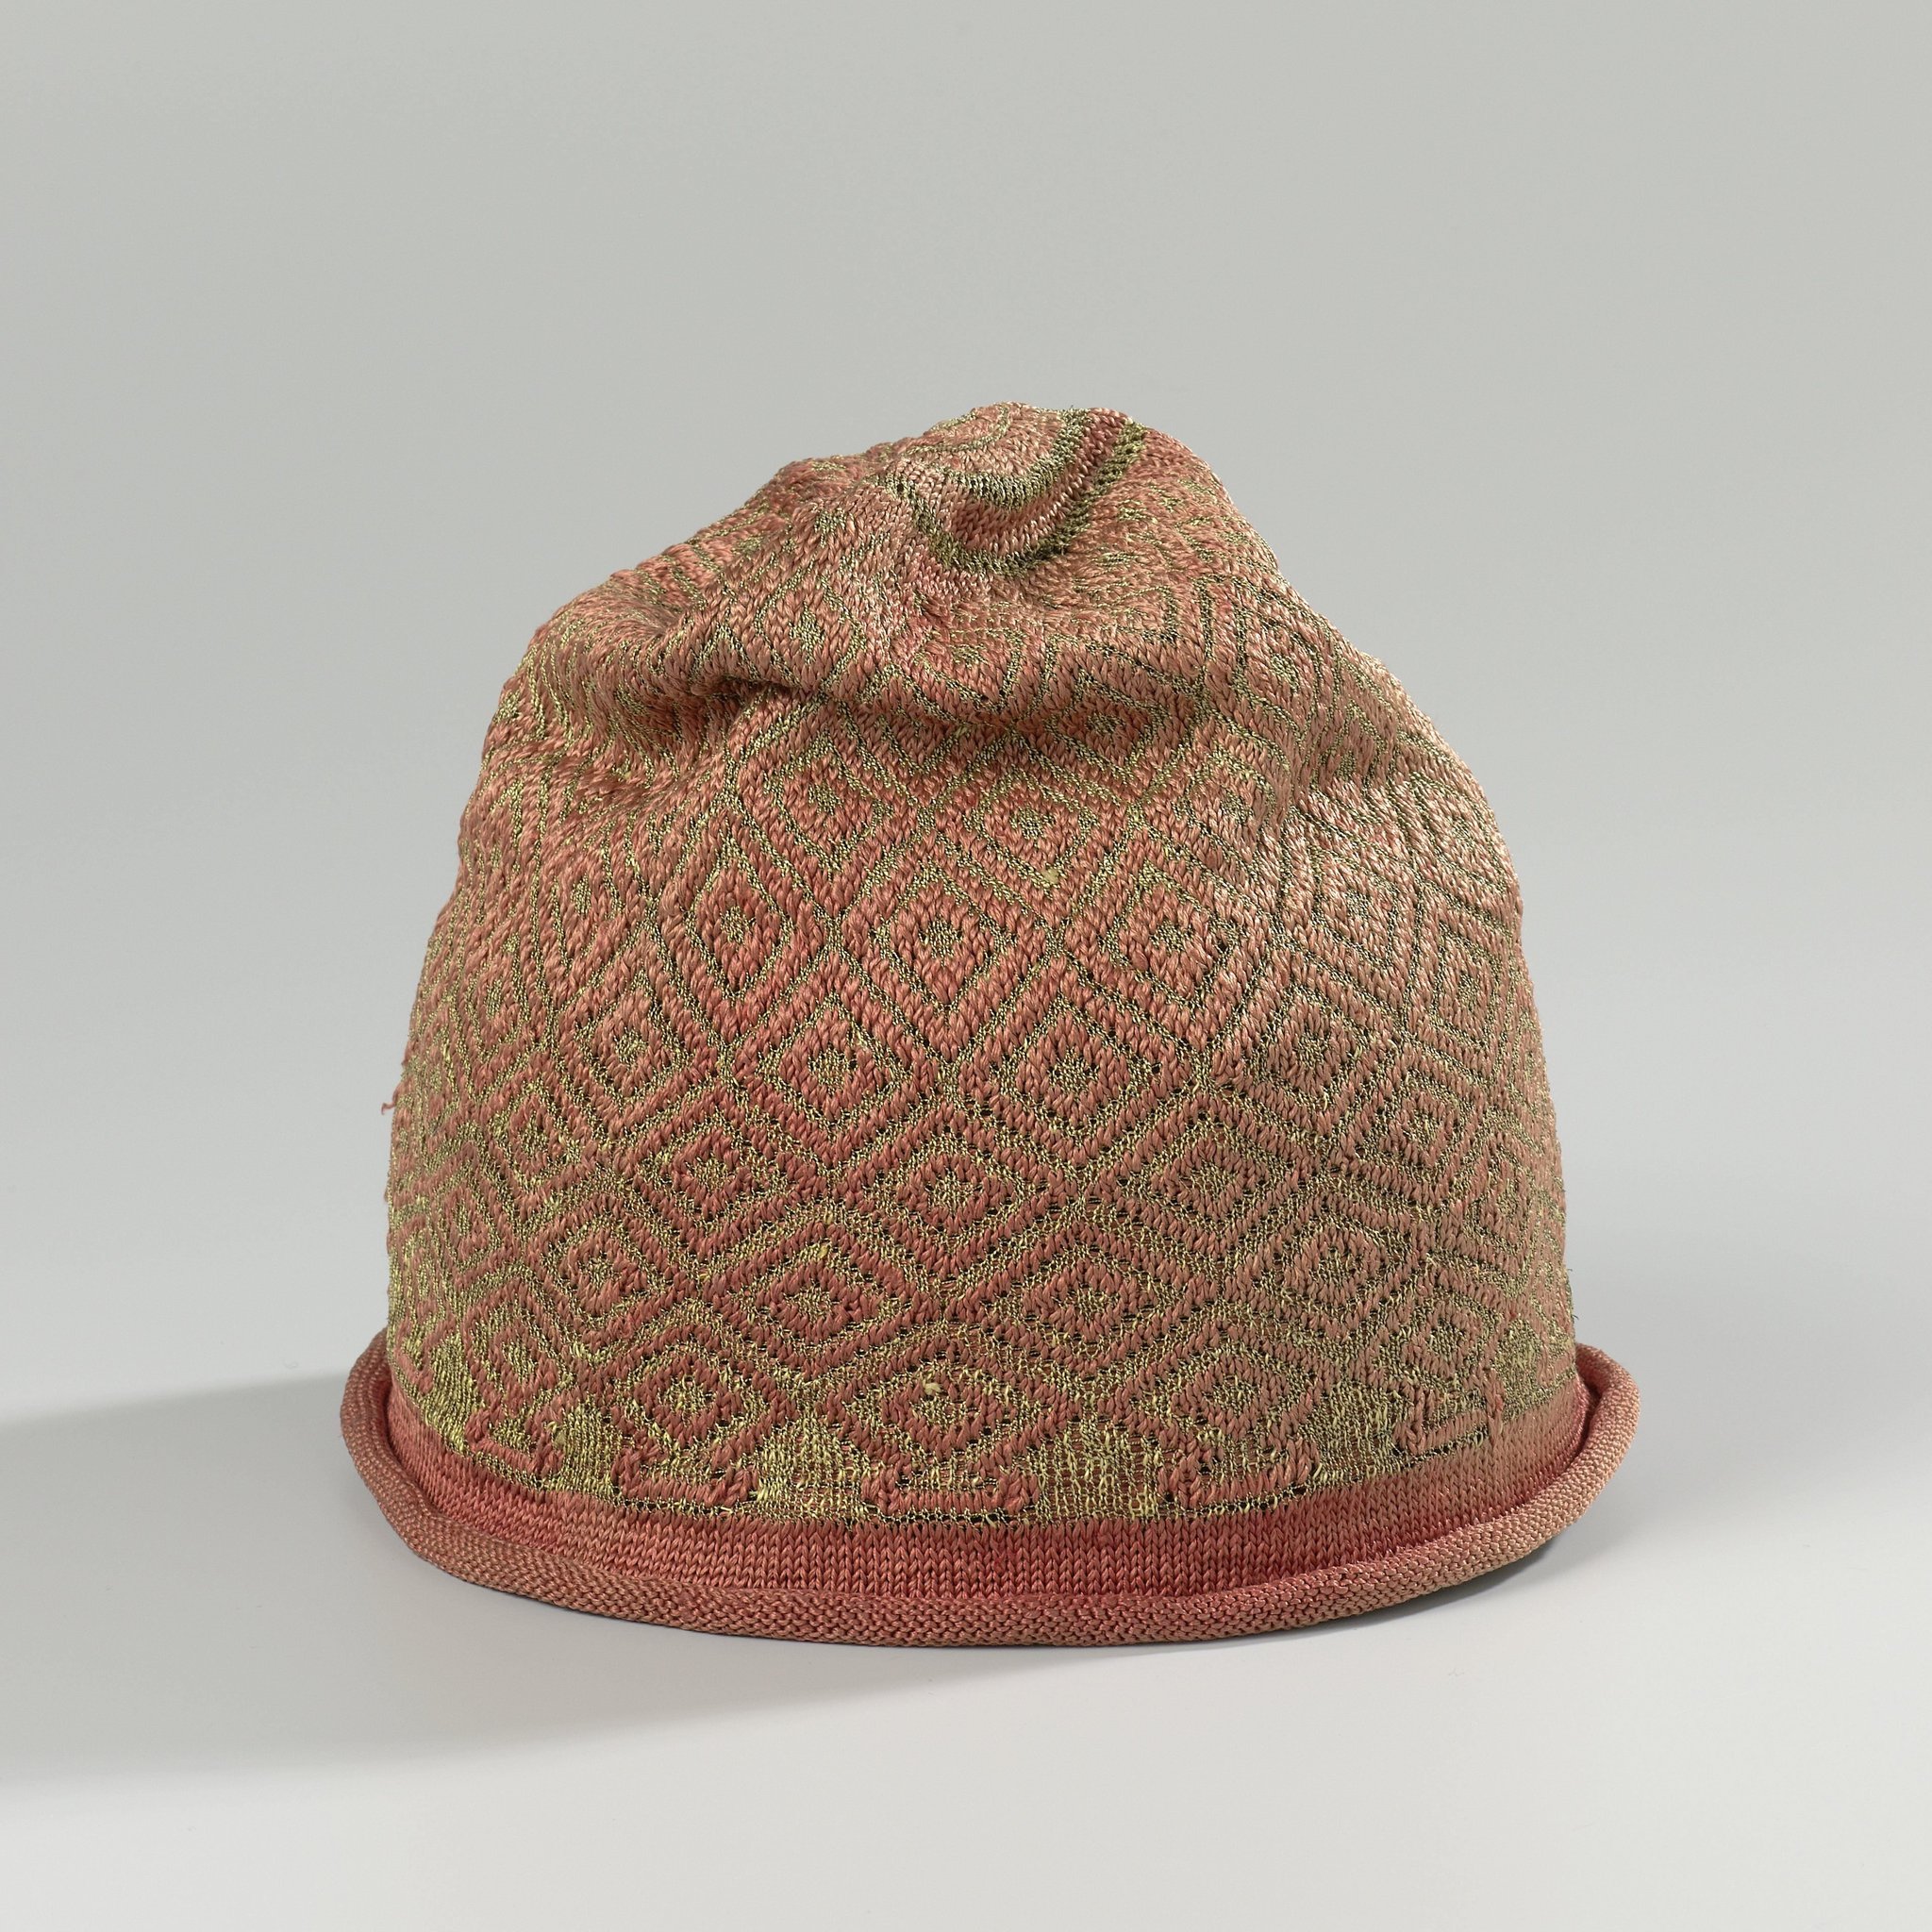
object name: night cap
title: Muts, gebreid met een bol van rode zijde met ruitvormige, geometrische ornamenten van gouddraad en een omgekrulde rand van effen rode zijde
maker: Anonymous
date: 1600-1699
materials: gold thread, silk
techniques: knitting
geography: england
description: Muts, gebreid met een bol van rode zijde met ruitvormige, geometrische ornamenten van gouddraad en een rand van effen rode zijde. Rond gebreid met vier of vijf naalden. Het gouddraad is meegebreid met de rode zijde. Middenachter een 'naad', waar geminderd is. Geheel recht gebreid. De versiering bevindt zich op de bol, de omgekrulde 'rand' is effen. De muts is hoogstwaarschijnlijk in vorm gebracht door stomen en oprekken, aangezien er haast niet gemeerderd of geminderd is om de vorm te bereiken.